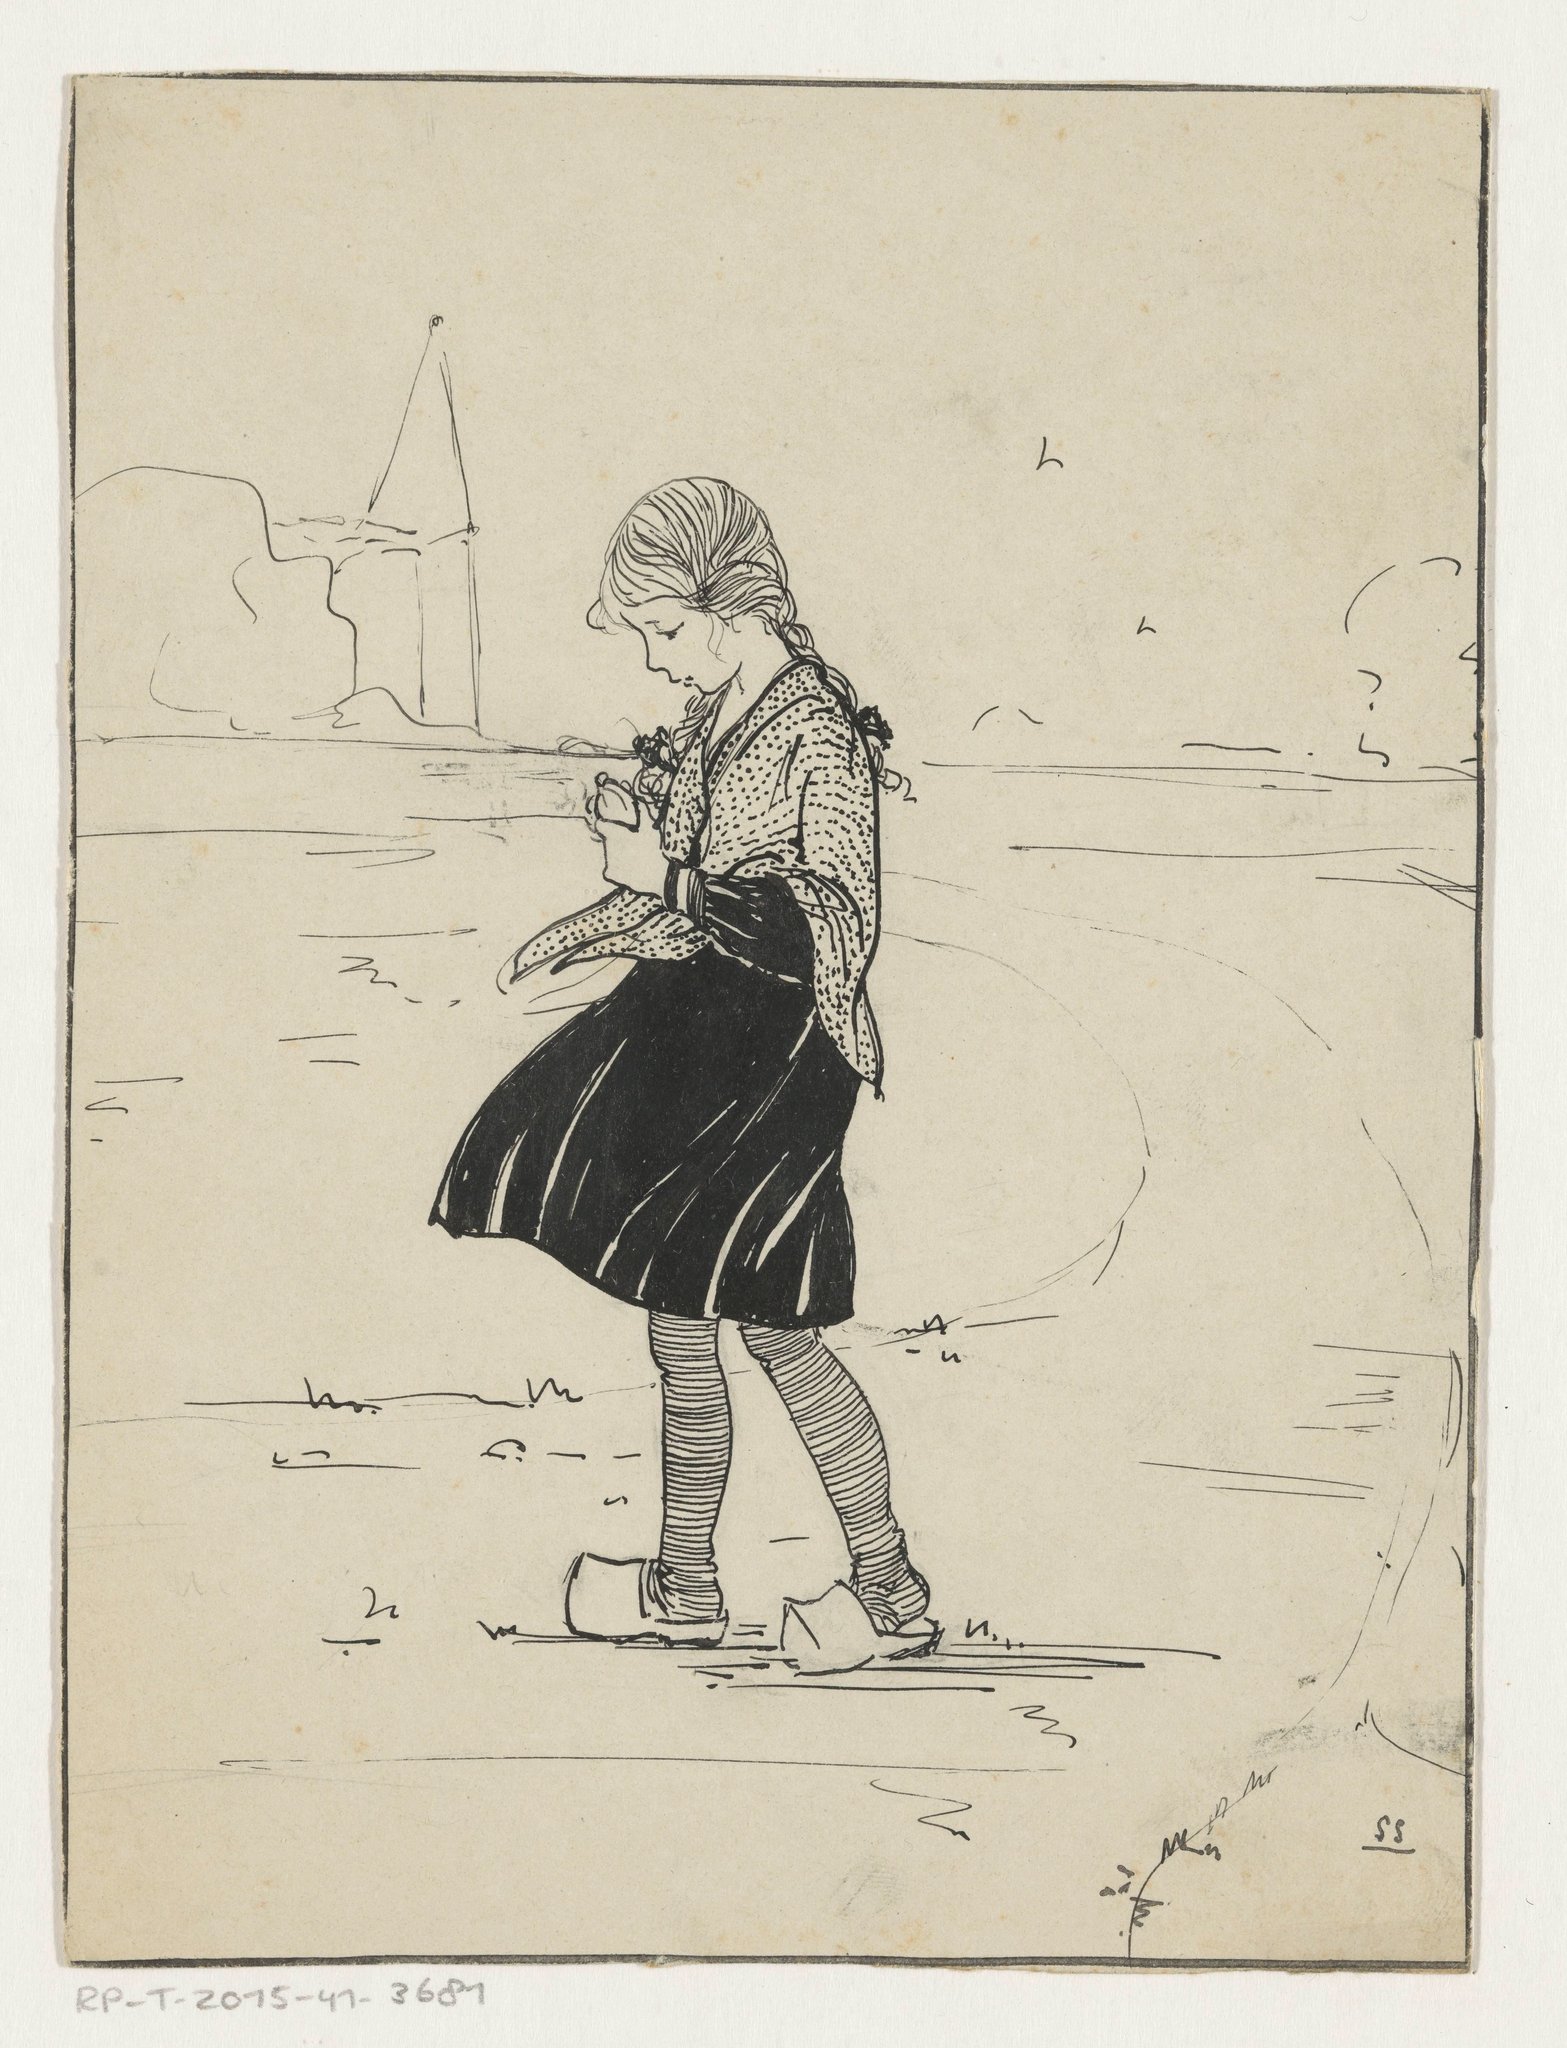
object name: drawing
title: Boerenmeisje in een weiland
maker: Anonymous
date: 1880-1930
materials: cardboard, ink, pencil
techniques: brush, pen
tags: wooden shoes, clogs, girl (child between toddler and youth)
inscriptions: collector's mark: Lugt 2228a, signature: ‘SS’, annotation: ‘Jan’, :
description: Een meisje op klompen staat in een weiland. Ze heeft een omslagdoek om en kijkt naar een voorwerp in haar handen. In de achtergrond bomen en een kerktoren.